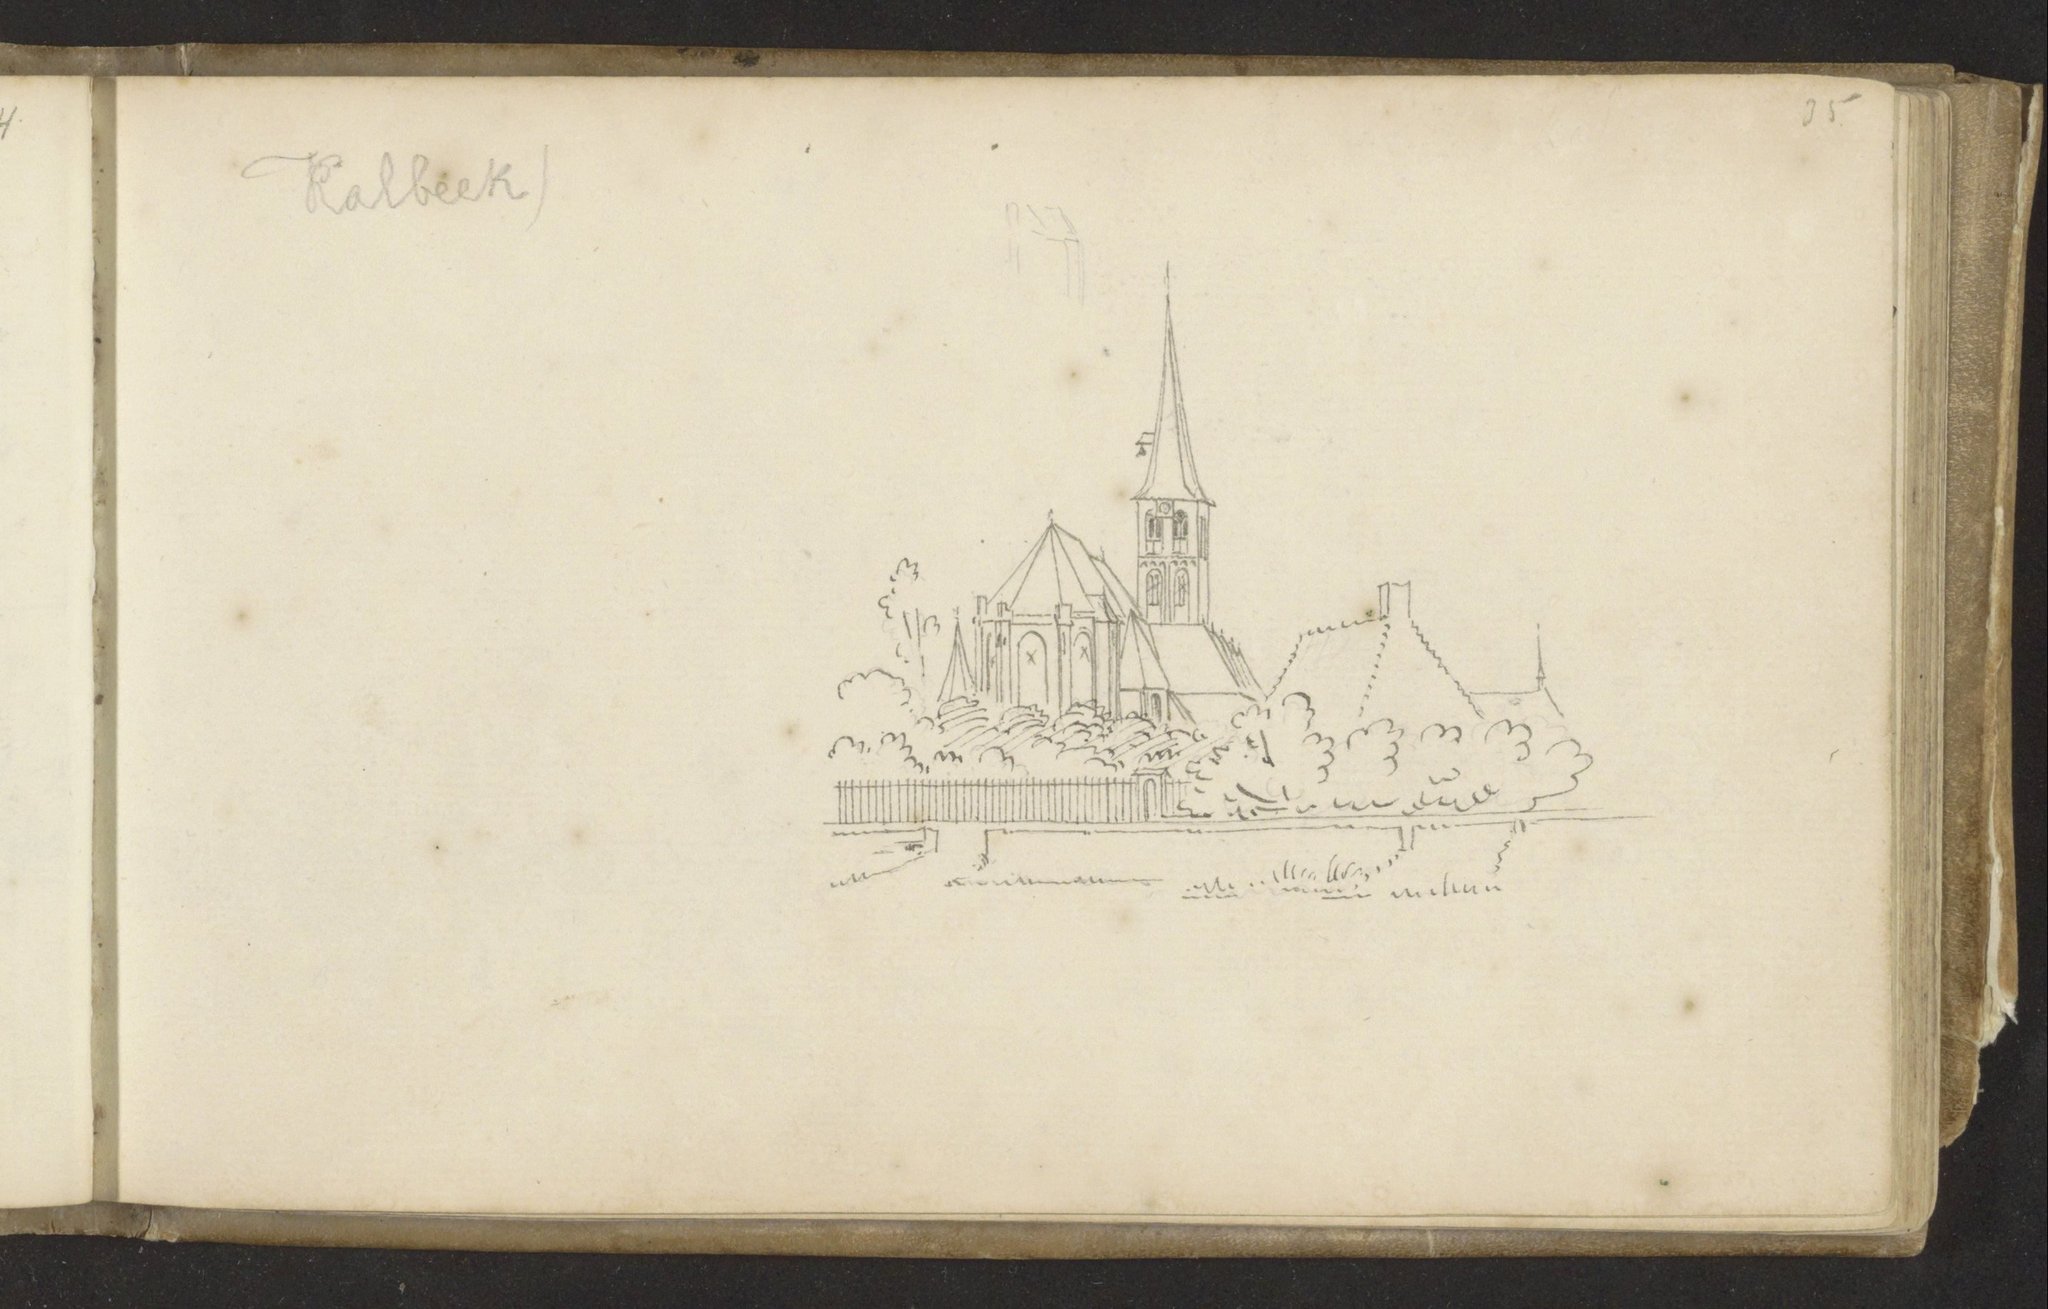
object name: sketchbook leaf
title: Kerk te Kalbeek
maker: abraham de haen (ii)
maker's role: draughtsman, print maker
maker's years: 1707-1748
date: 1731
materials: ink, paper, pencil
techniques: pen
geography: kalbeek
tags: prospect of village, silhouette of village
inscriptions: annotation: ‘Kalbeek’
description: Blad 35 recto uit een schetsboek met 69 bladen.